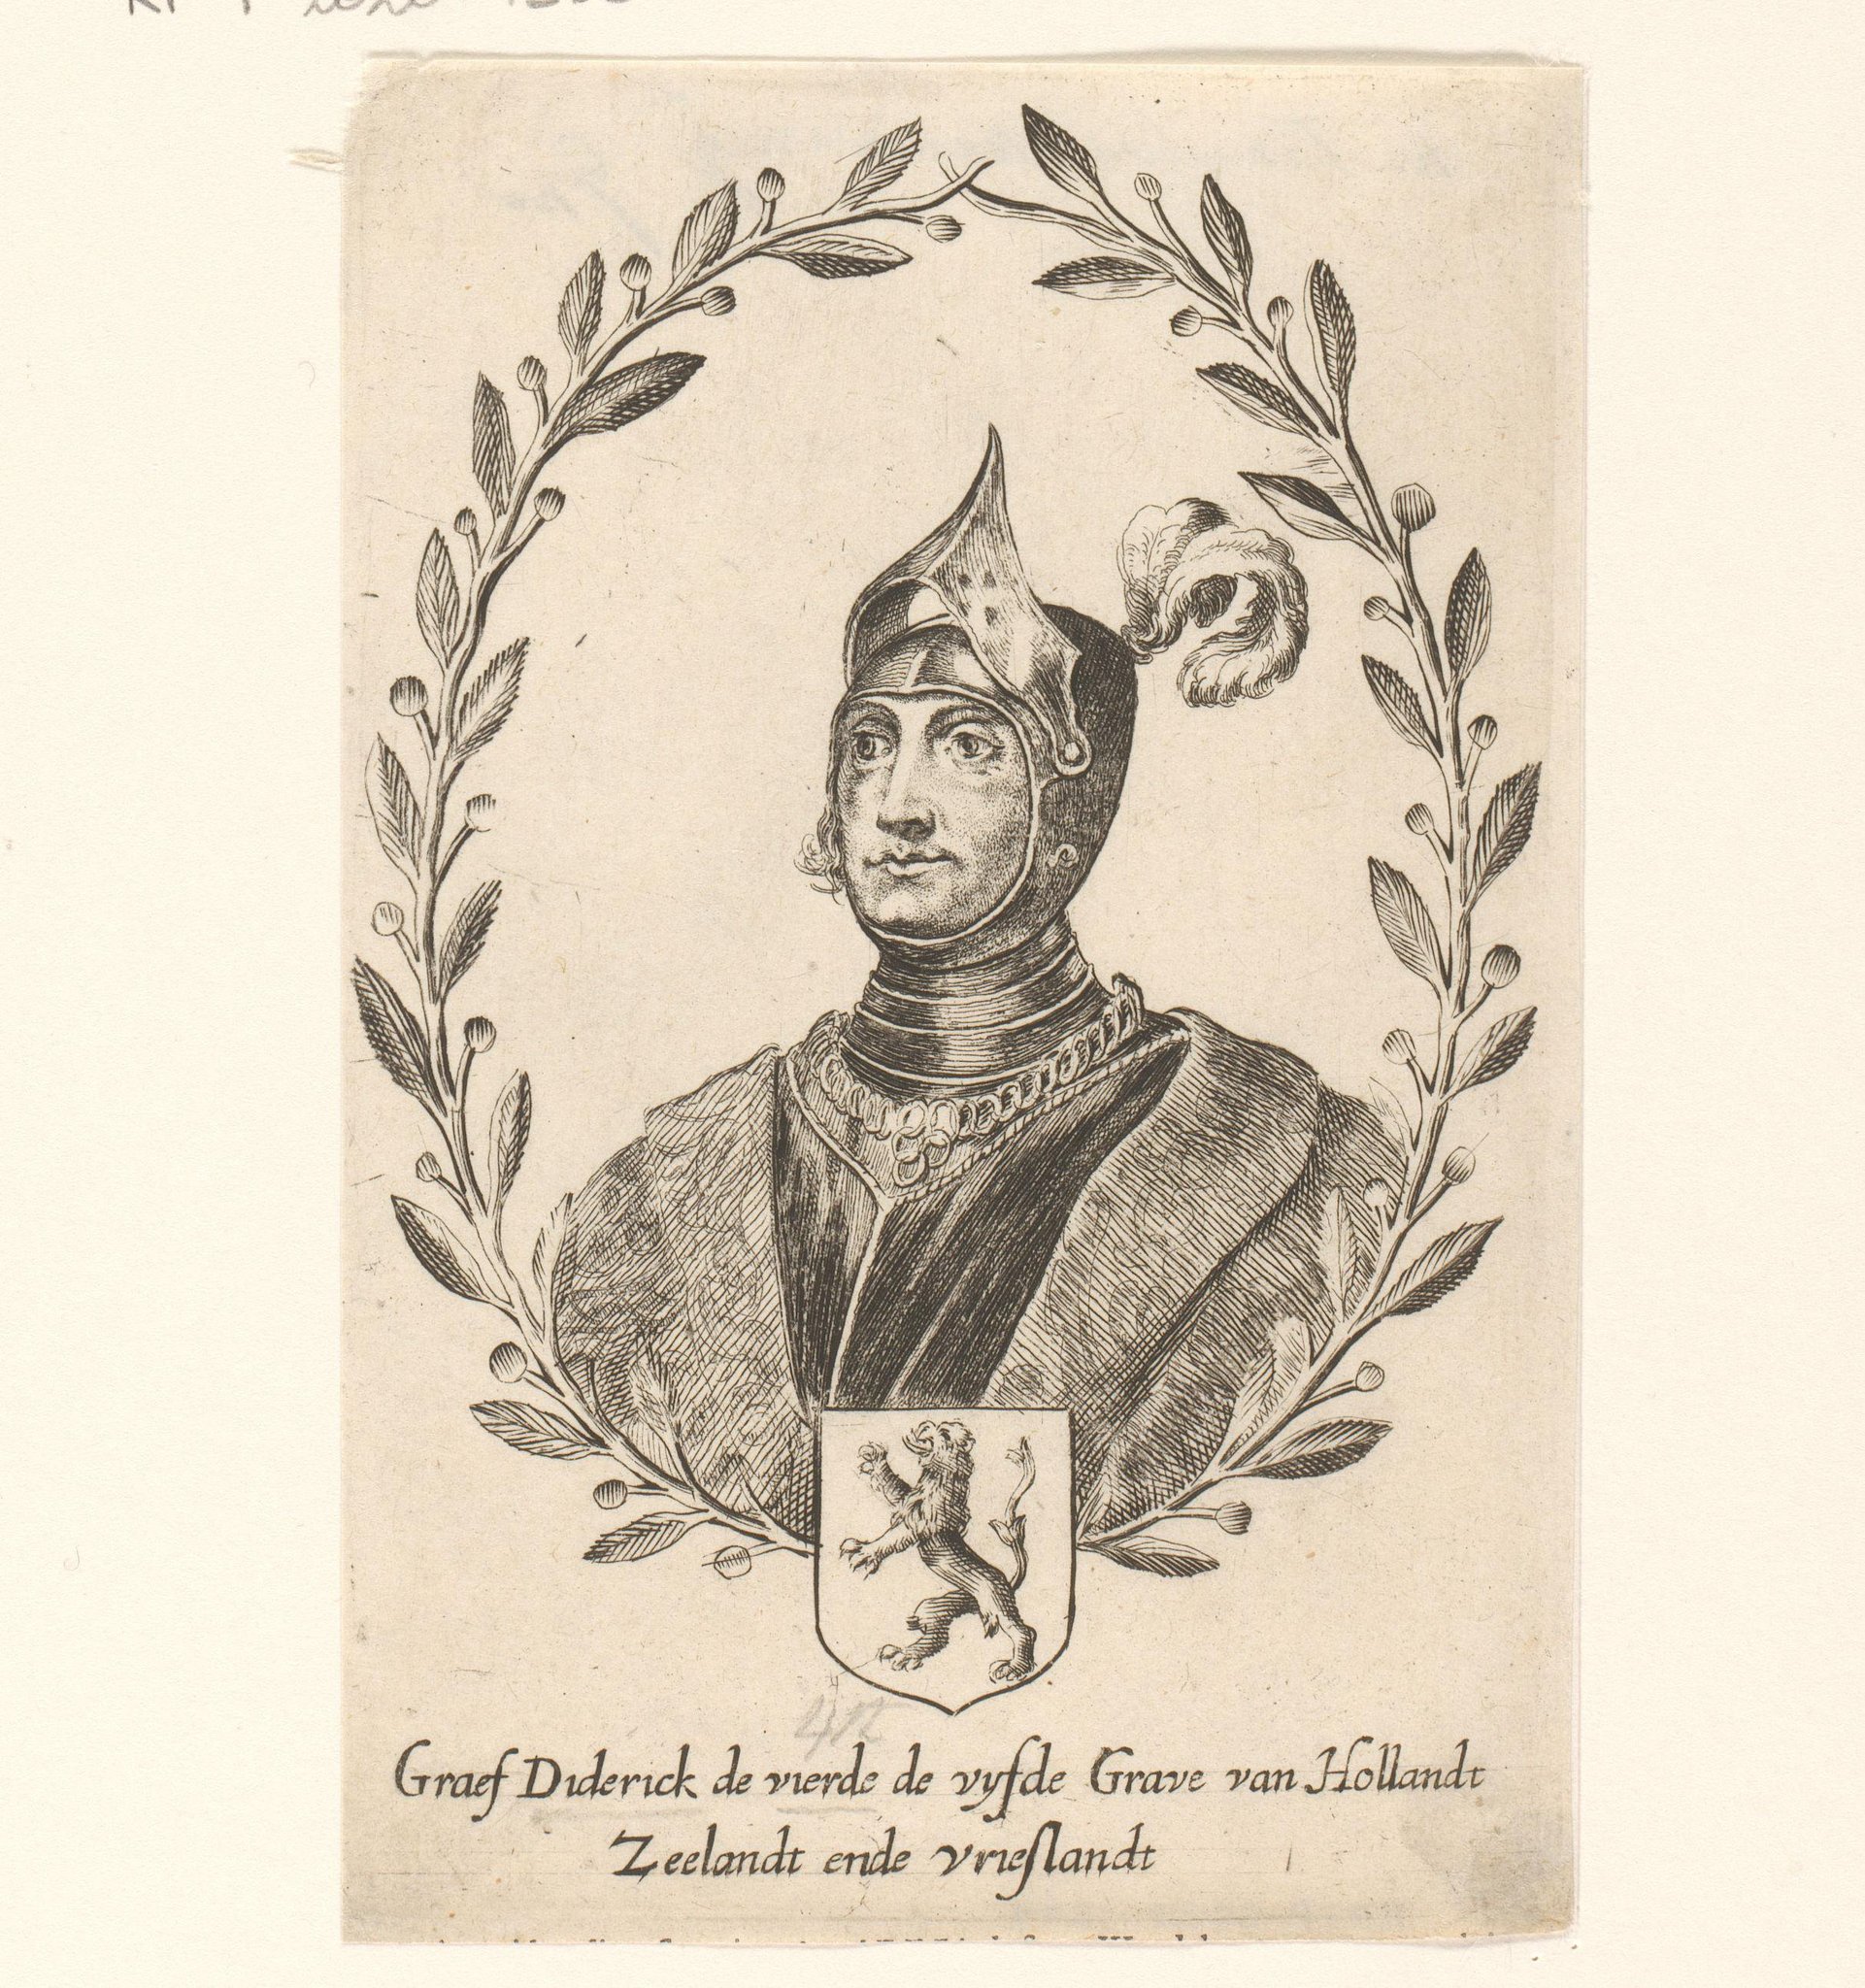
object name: print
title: Graef Diderick de vierde de vyfde grave van Hollandt Zeelandt ende Vrieslandt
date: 1677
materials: paper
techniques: engraving, etching, letterpress printing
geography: the hague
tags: historical persons, ruler, sovereign, armorial bearing, heraldry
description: Prent uit: Scriverius, Petrus. Hollandsche, Zeelandsche ende Vriesche chronyck. Den Haag: Jasper Doll en Johan Veely, 1677, p. 66.